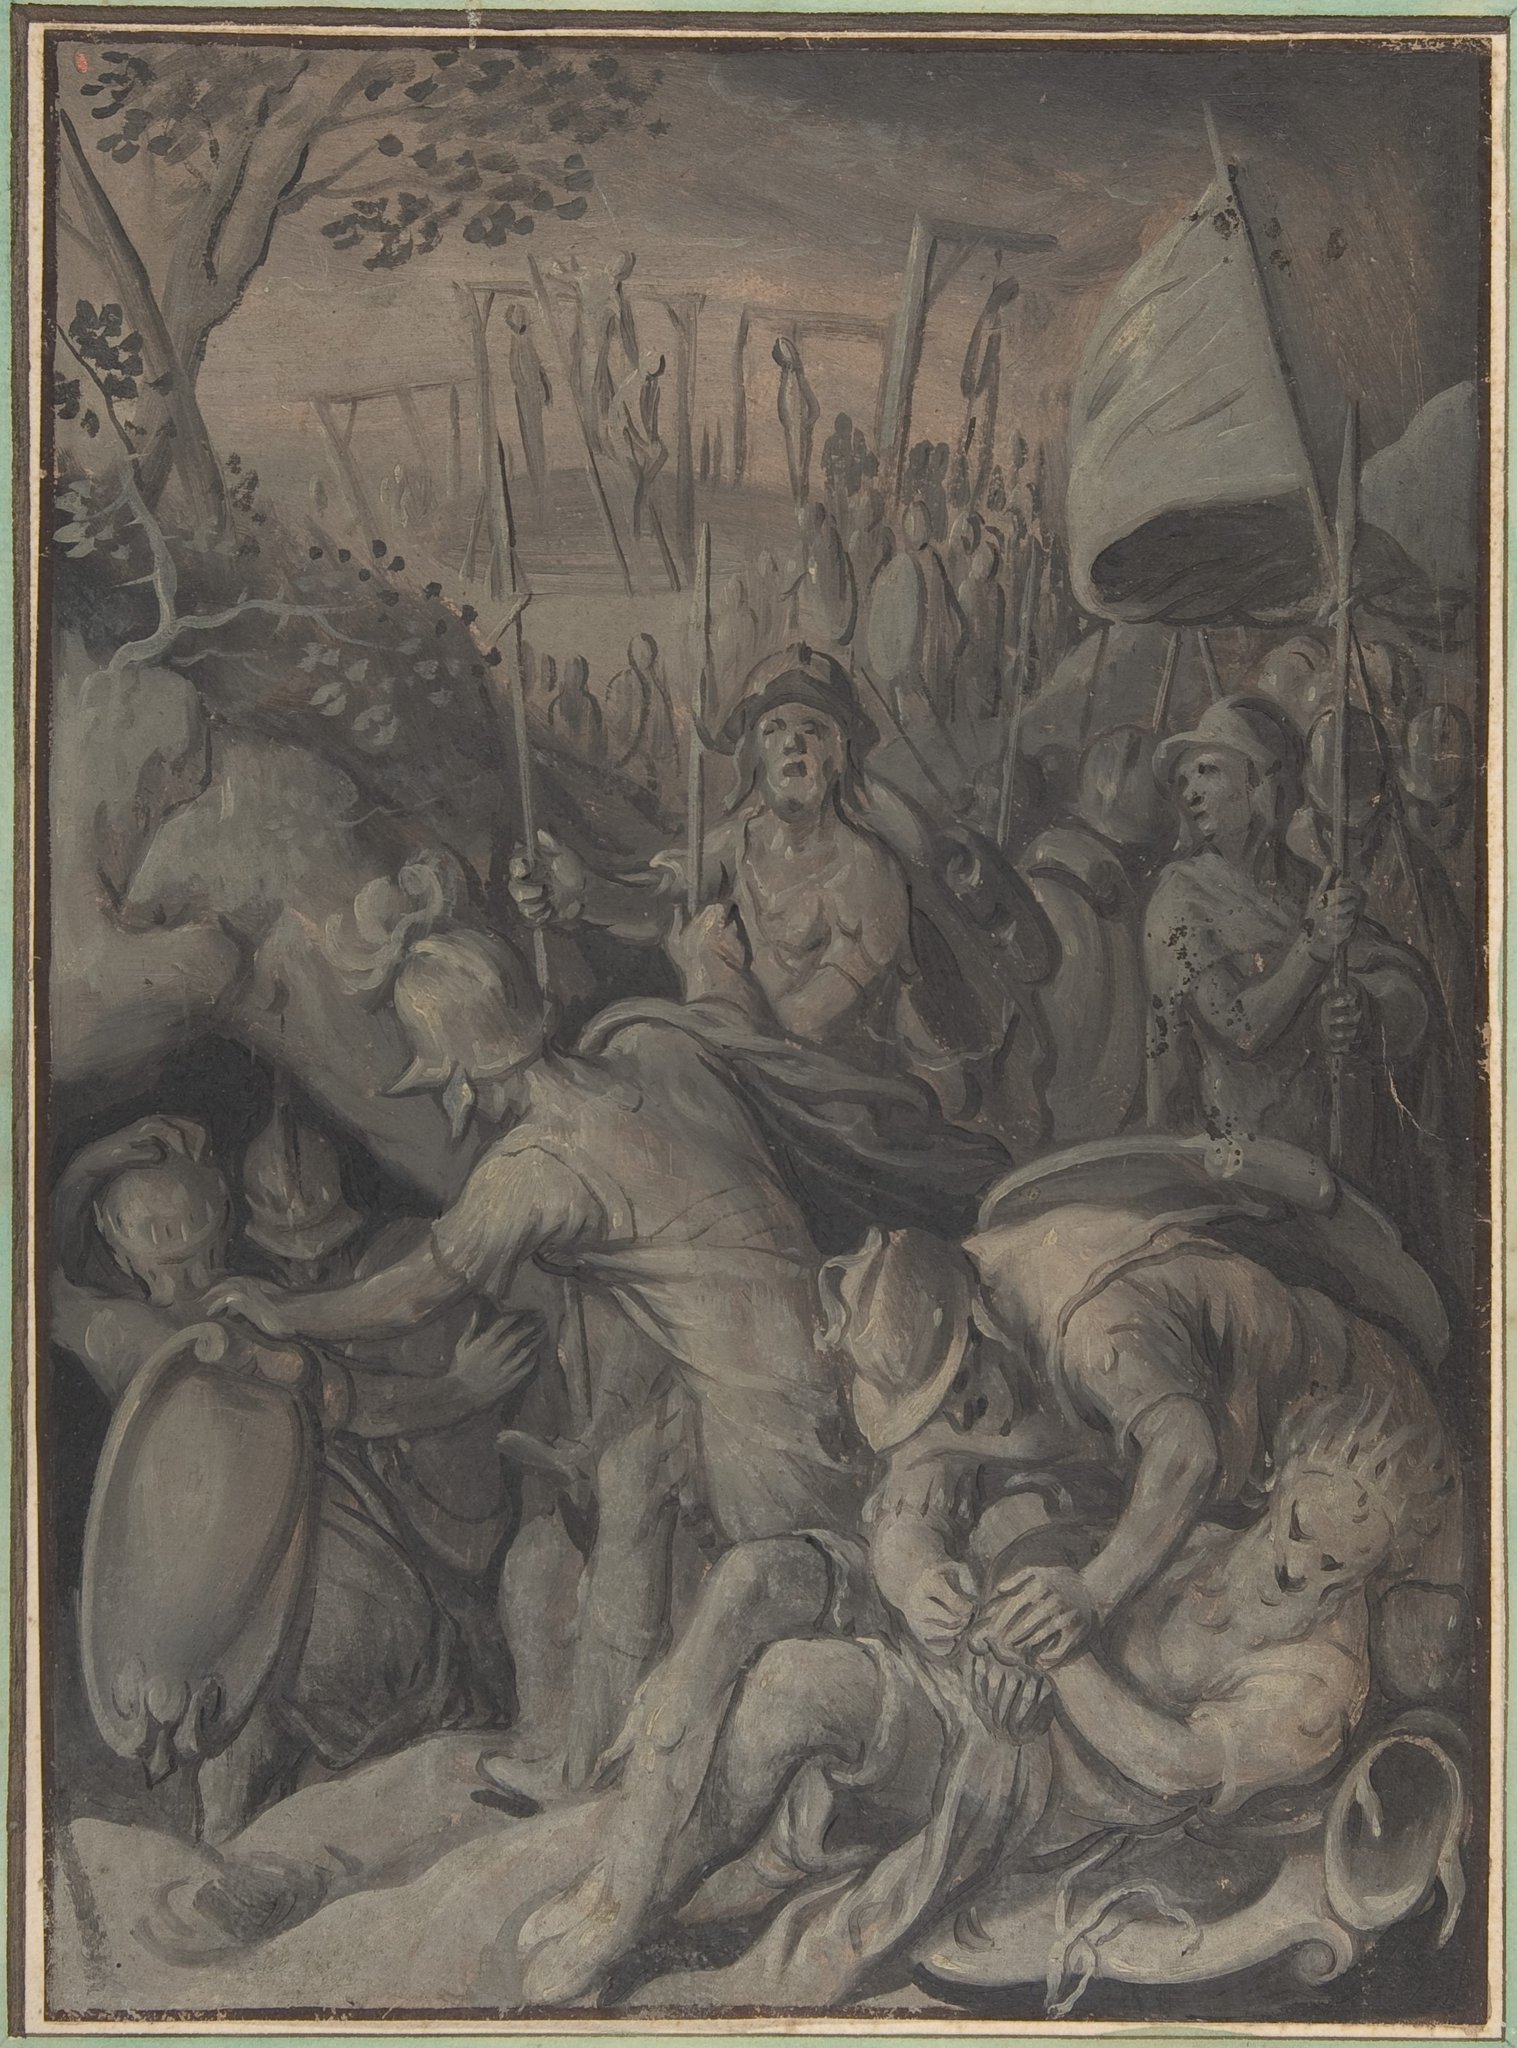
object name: drawing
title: Execution of the Five Kings of the Amorites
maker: joachim beuckelaer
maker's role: artist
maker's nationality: netherlandish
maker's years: 1533-1574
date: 1533-1574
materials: oil, paper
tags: soldiers,spears,kings,flags,execution